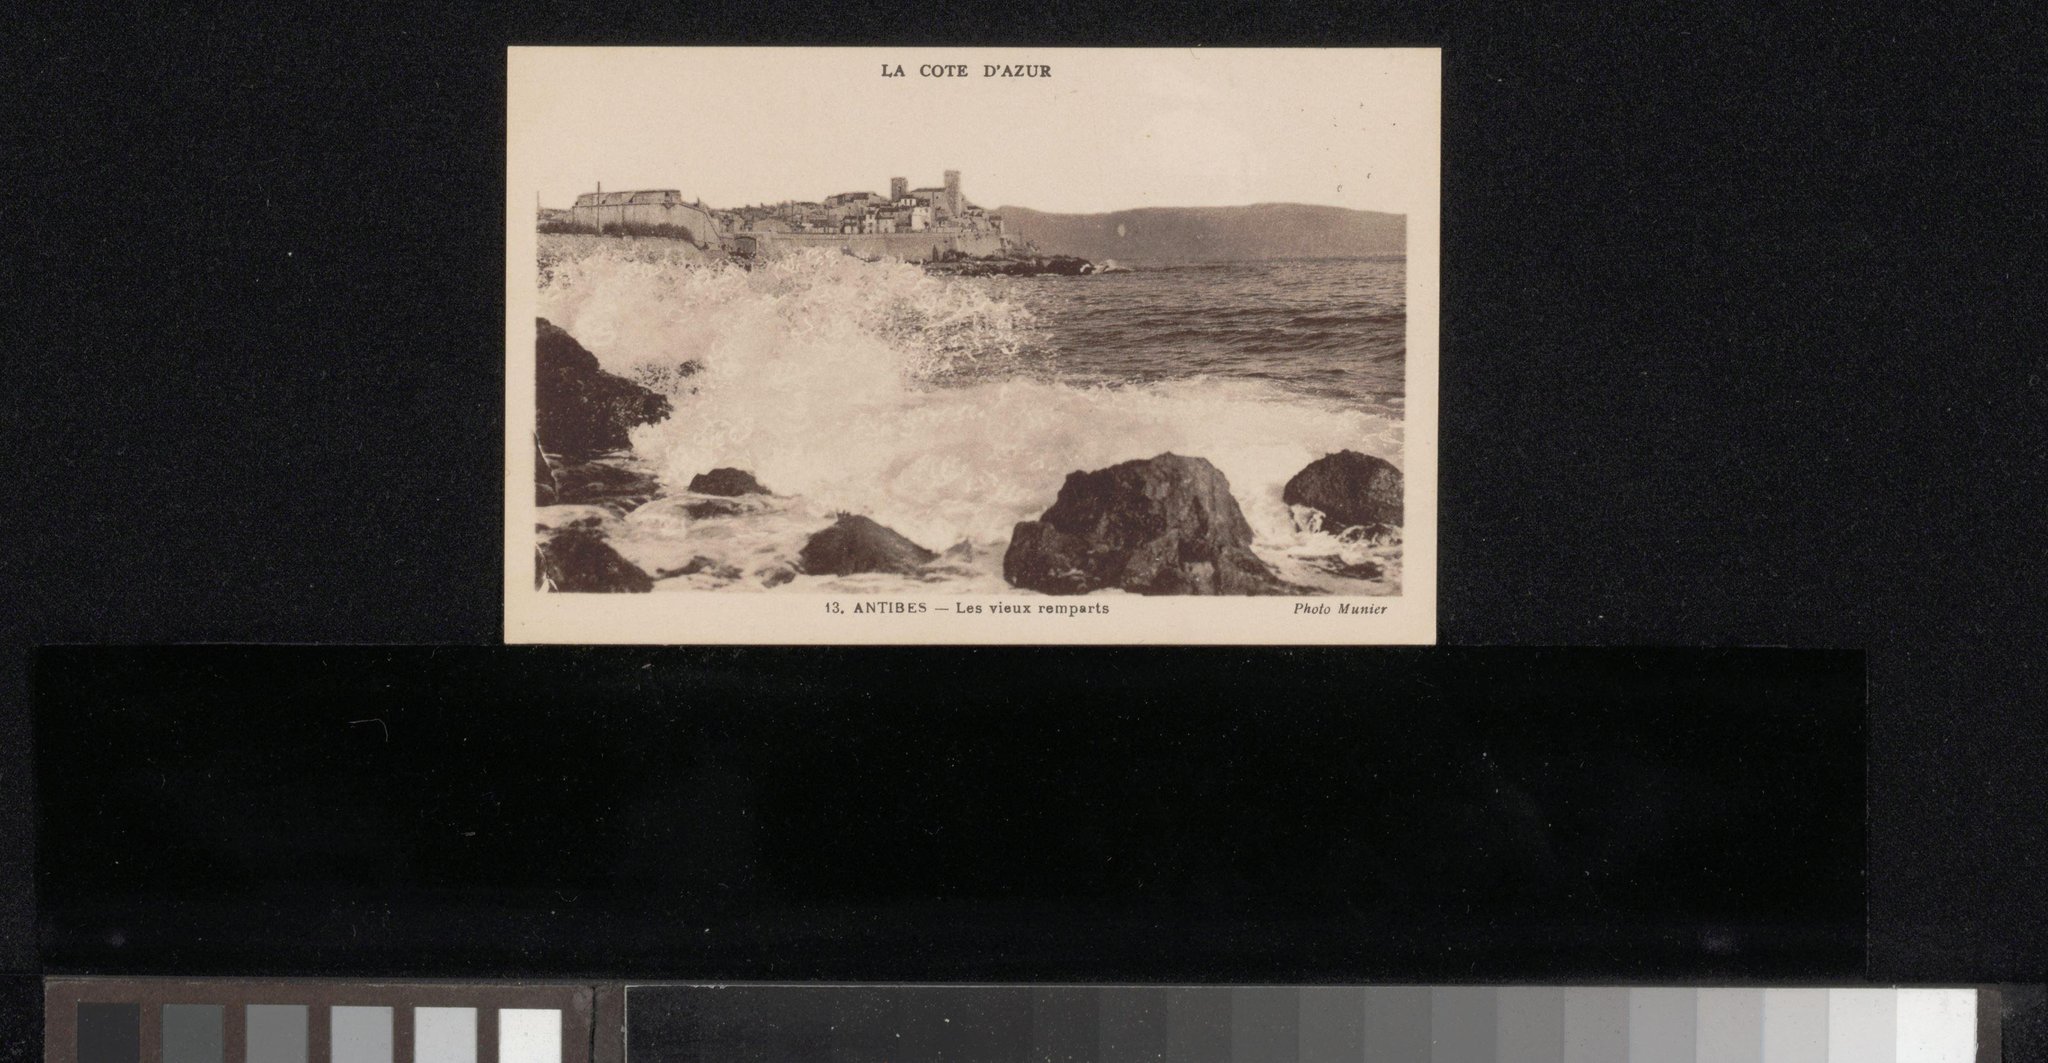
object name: ansichtkaart, prentbriefkaart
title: Prentbriefkaart aan Willem Bogtman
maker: richard nicolaüs roland holst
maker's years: 1868-1938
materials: cardboard, ink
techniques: photograph, pen, writing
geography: nice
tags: willem bogtman, amsterdam, henriëtte roland holst-van der schalk, applied arts, arts and crafts; industrial design, diseases